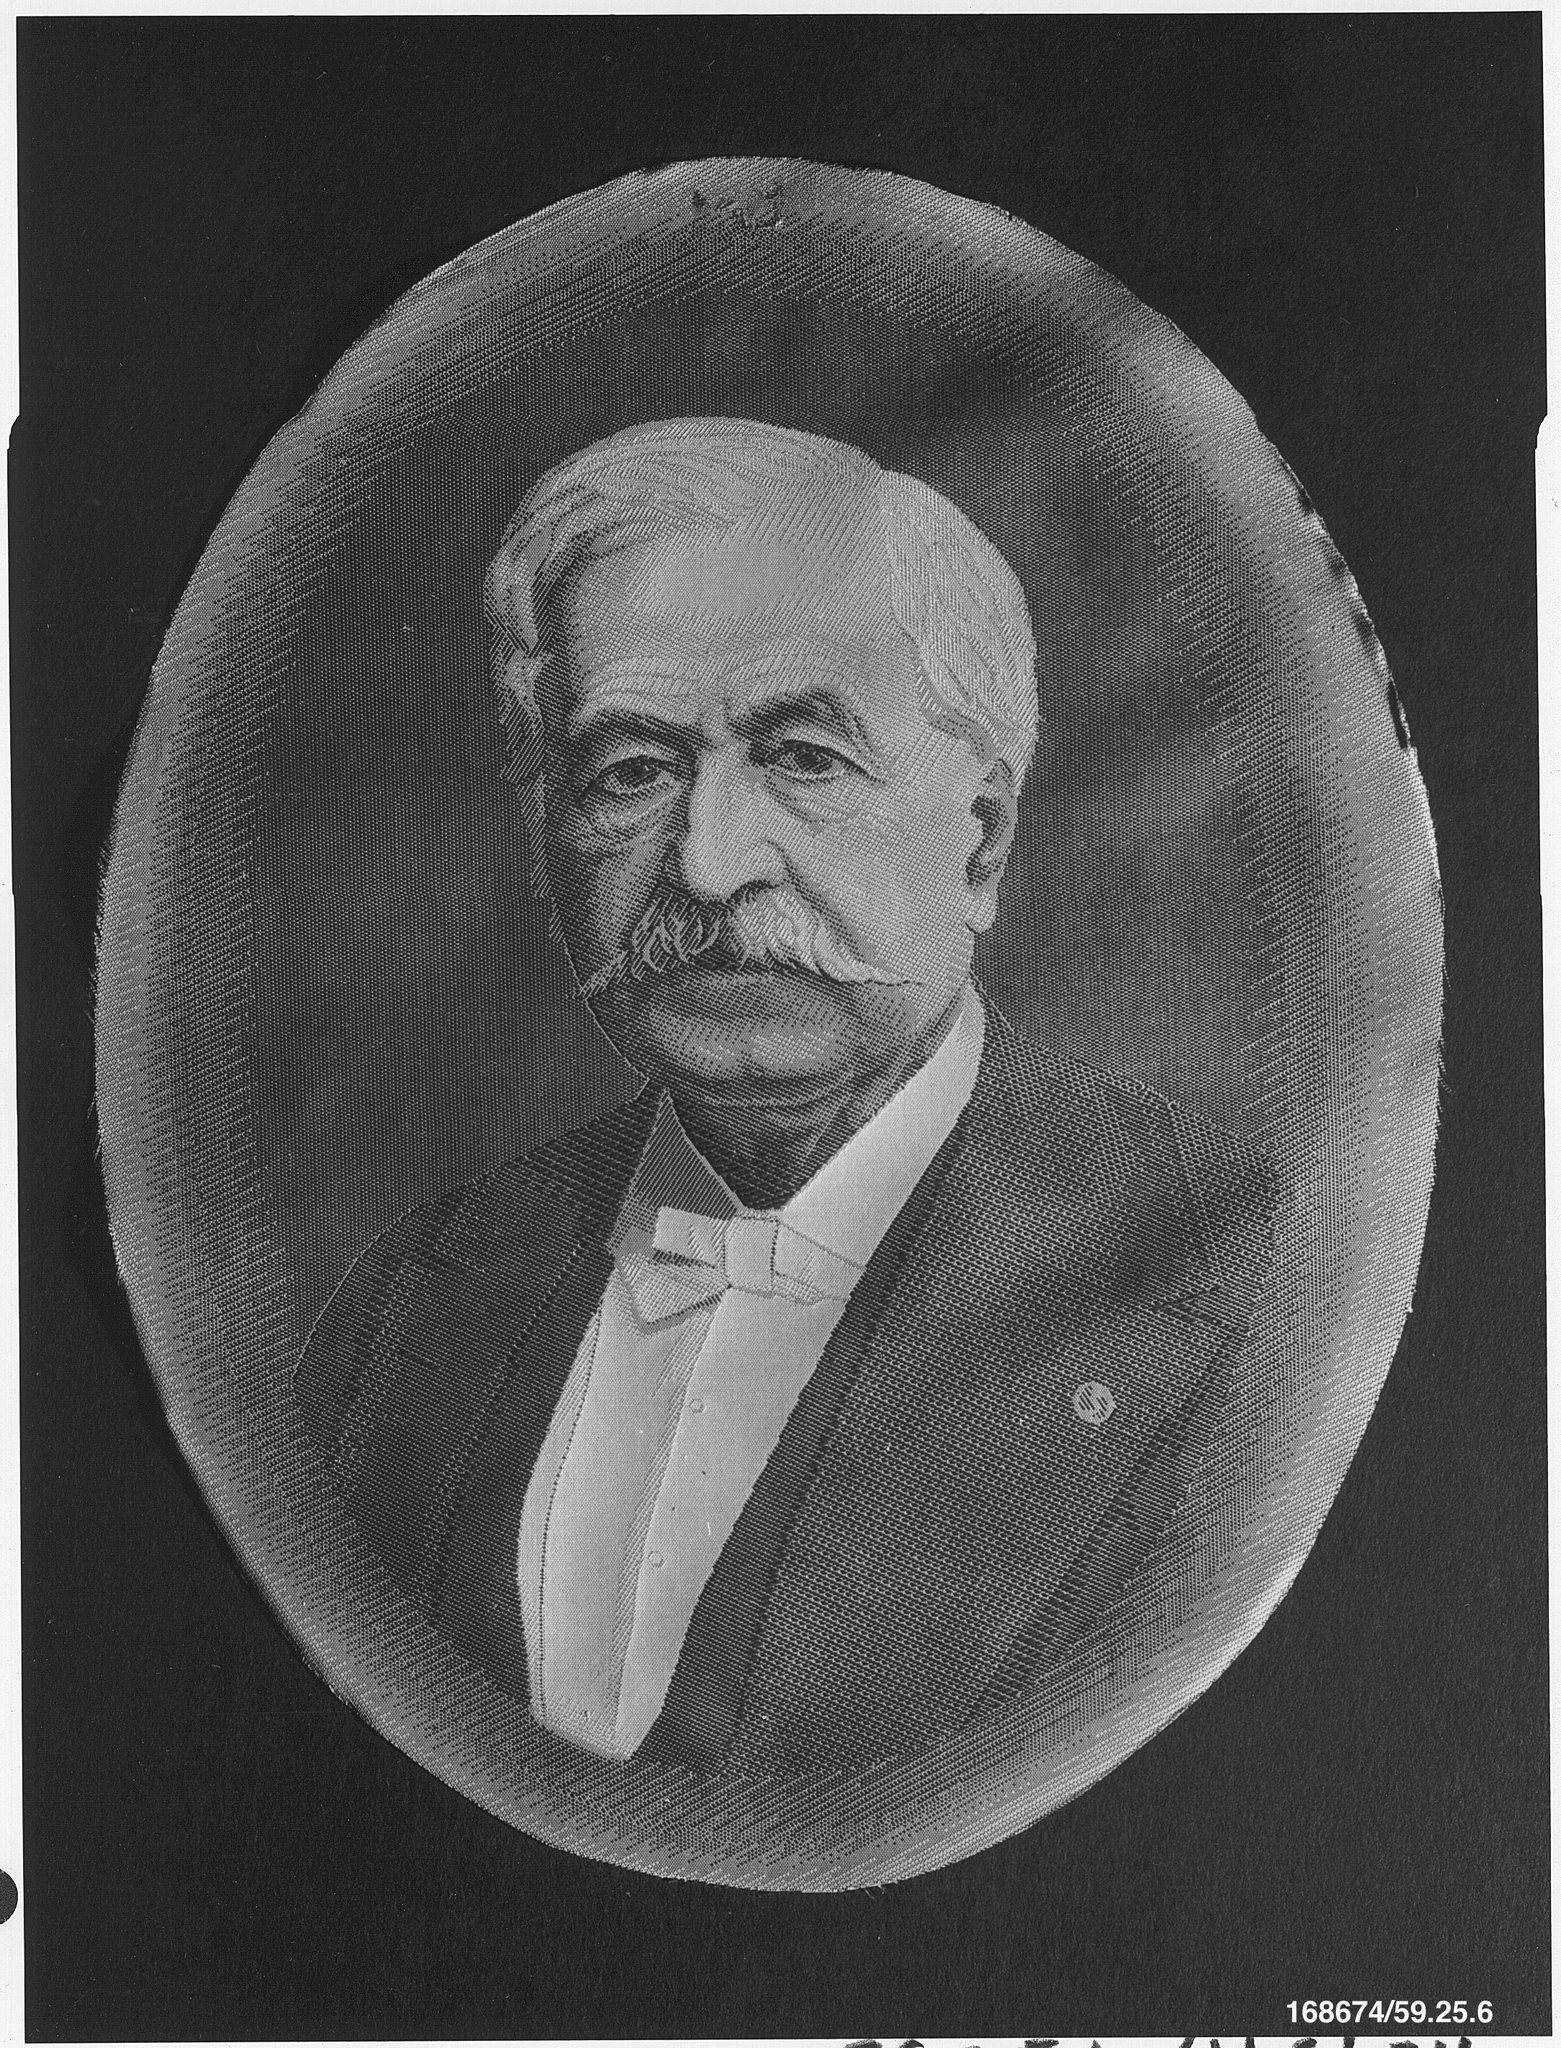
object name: portrait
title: Ferdinand de Lesseps (1805–1894)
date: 1888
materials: silk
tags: men,portraits